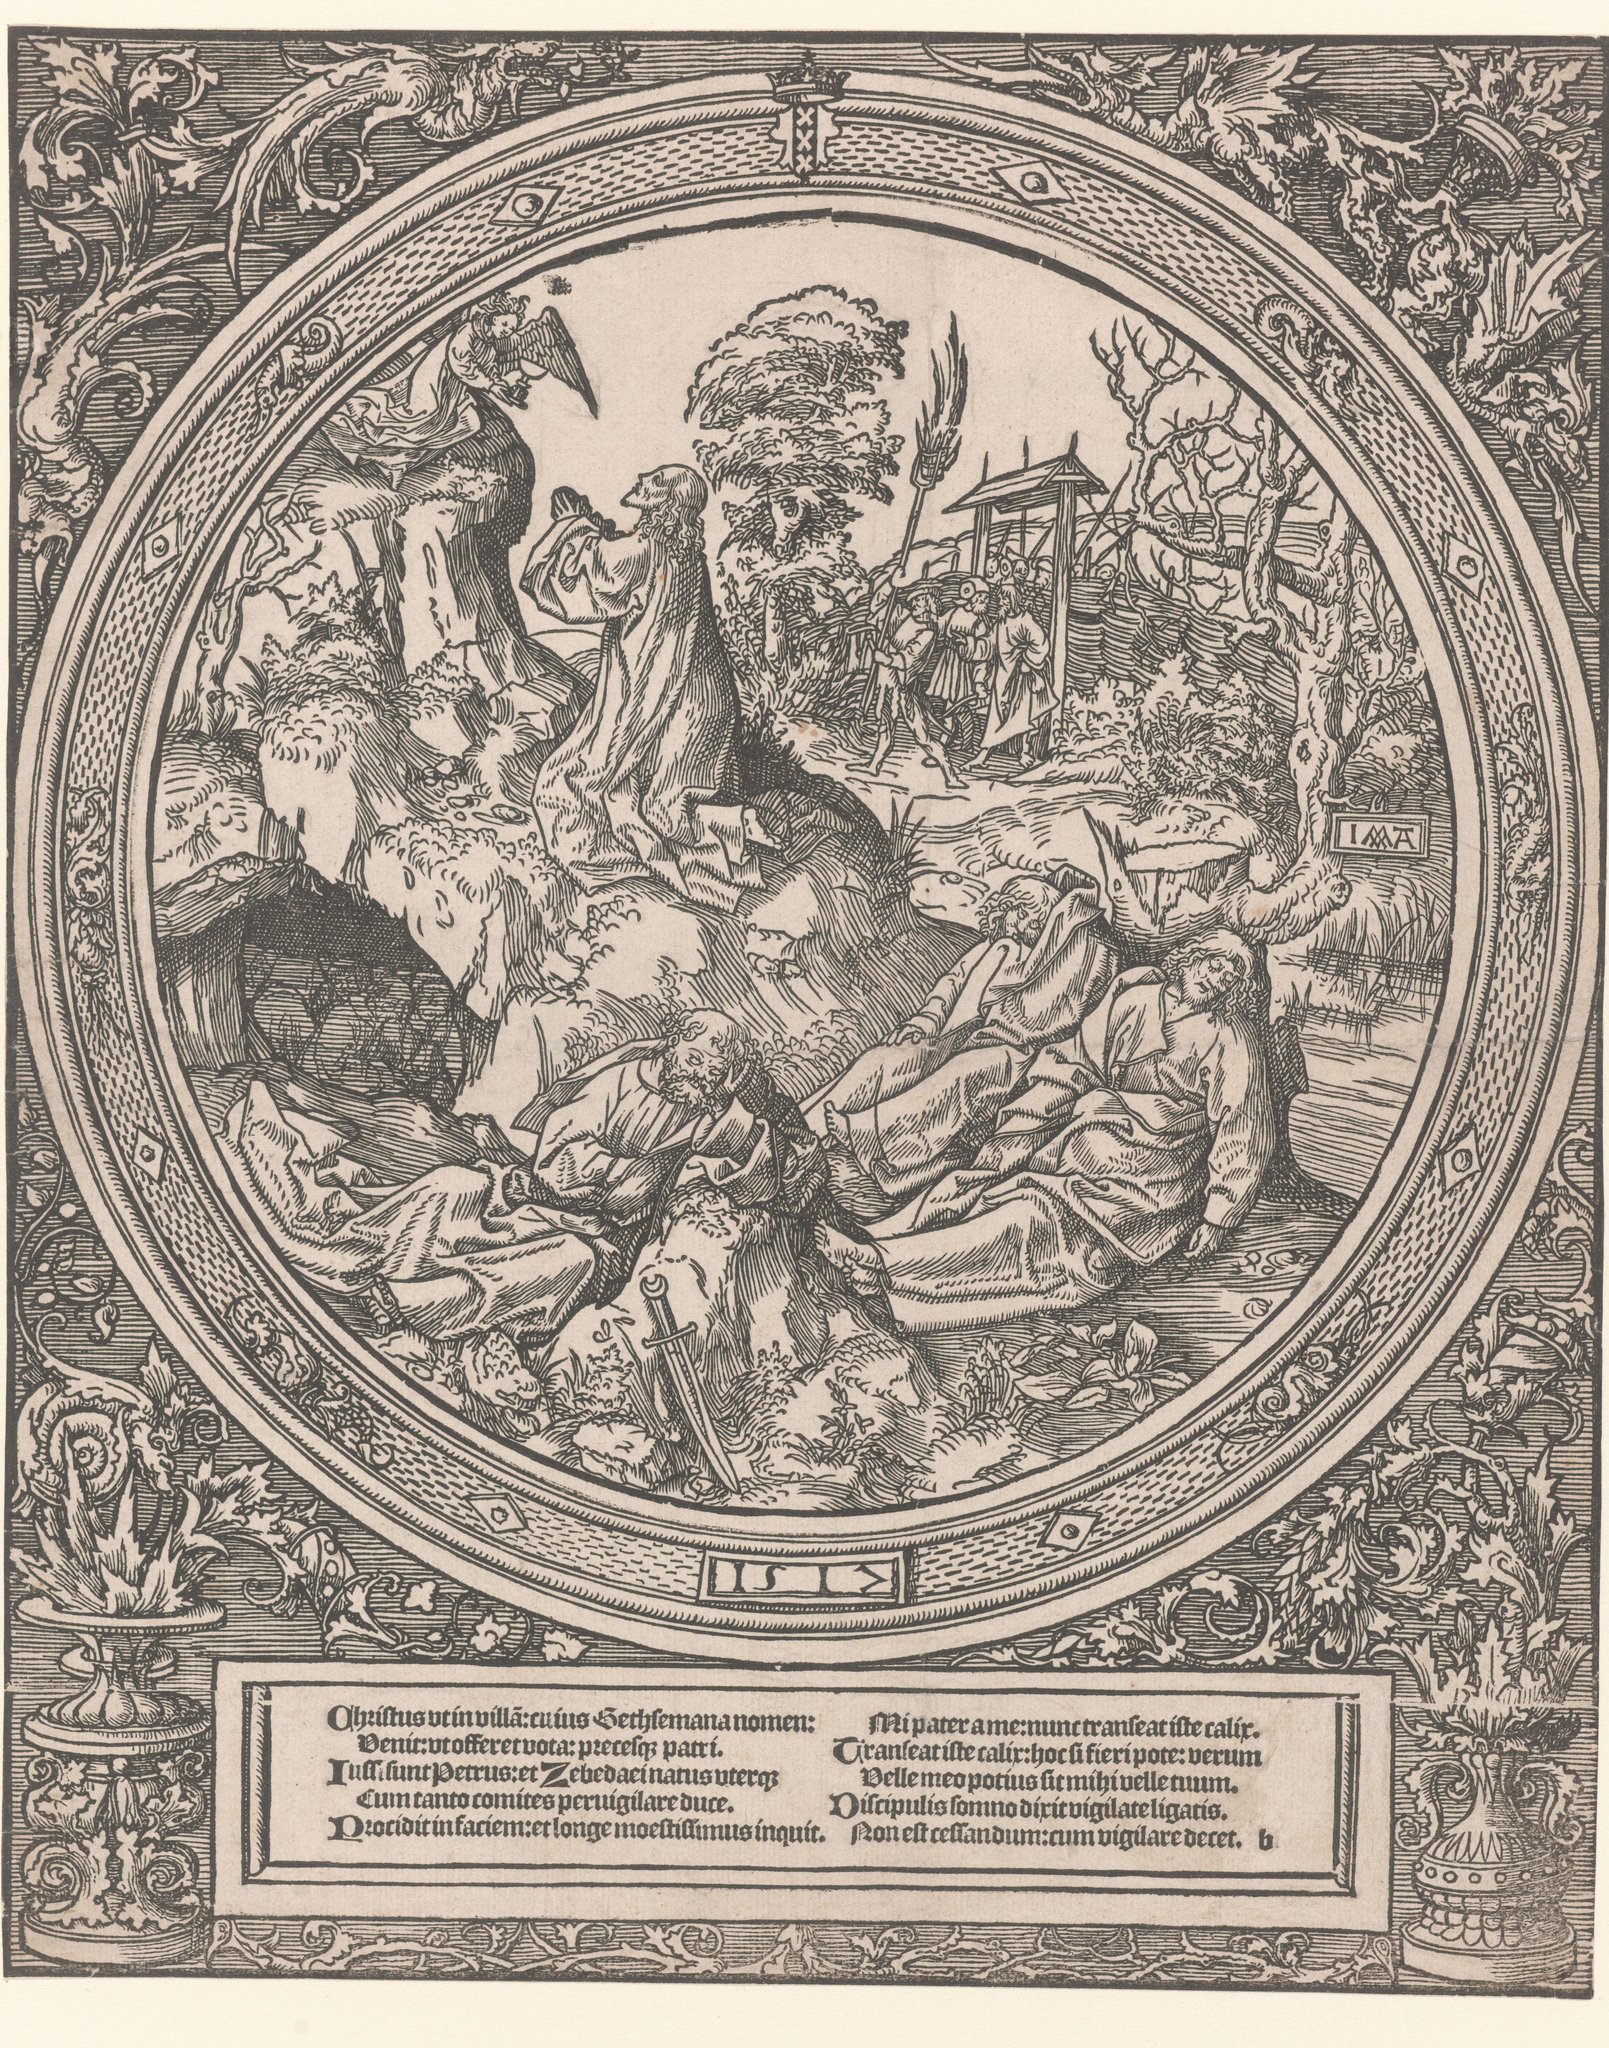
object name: print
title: De Ronde Passie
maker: jacob cornelisz van oostsanen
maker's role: draughtsman, painter, print maker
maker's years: 1475-1533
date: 1517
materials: paper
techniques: woodcut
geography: low countries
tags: agony of christ: to comfort him one or more angels appear to christ with chalice and/or cross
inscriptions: collector's mark: Lugt 2165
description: Uit serie van twaalf prenten. Christus biddend op de olijfberg, drie discipelen slapen. Rond voorstelling ornamentele omlijsting. Onderaan kader met tekst in het Latijn. Gedrukt van meerdere blokken.